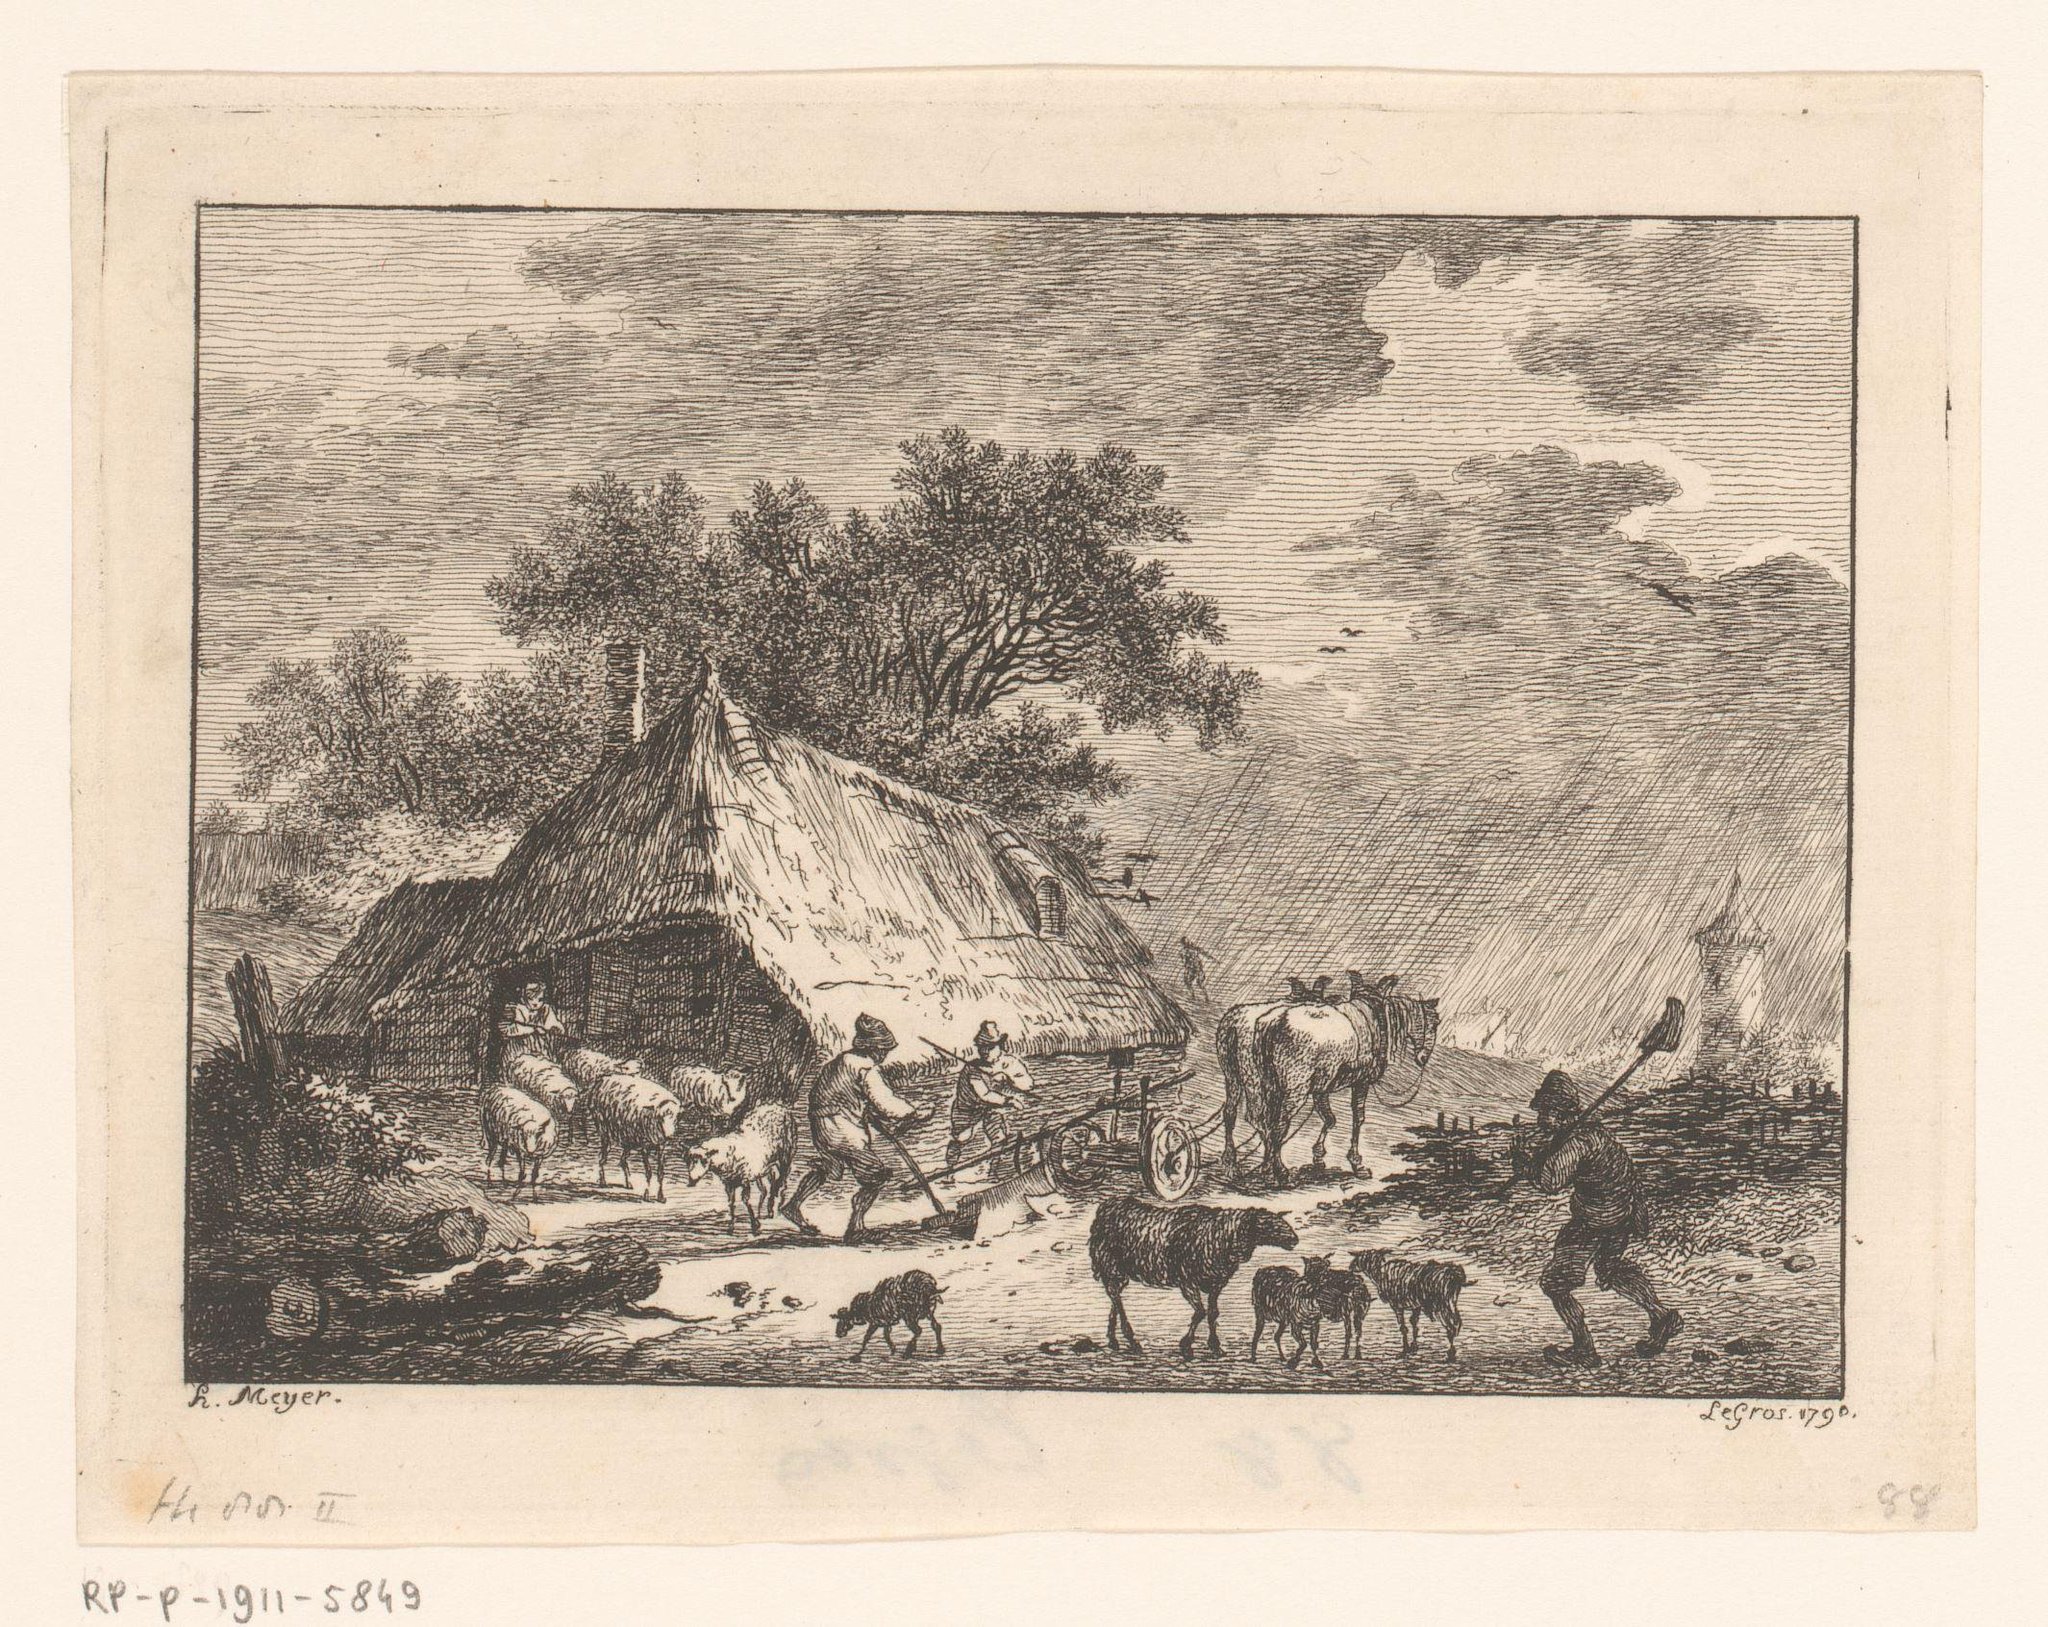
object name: print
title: Boerderij met verschillende figuren en een schapenhoedster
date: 1790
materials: paper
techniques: etching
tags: herding, herdsman, herdswoman, shepherd, shepherdess, cowherd, etc., sheep, farm (building)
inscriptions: collector's mark: Lugt 1485, collector's mark: Lugt 2228